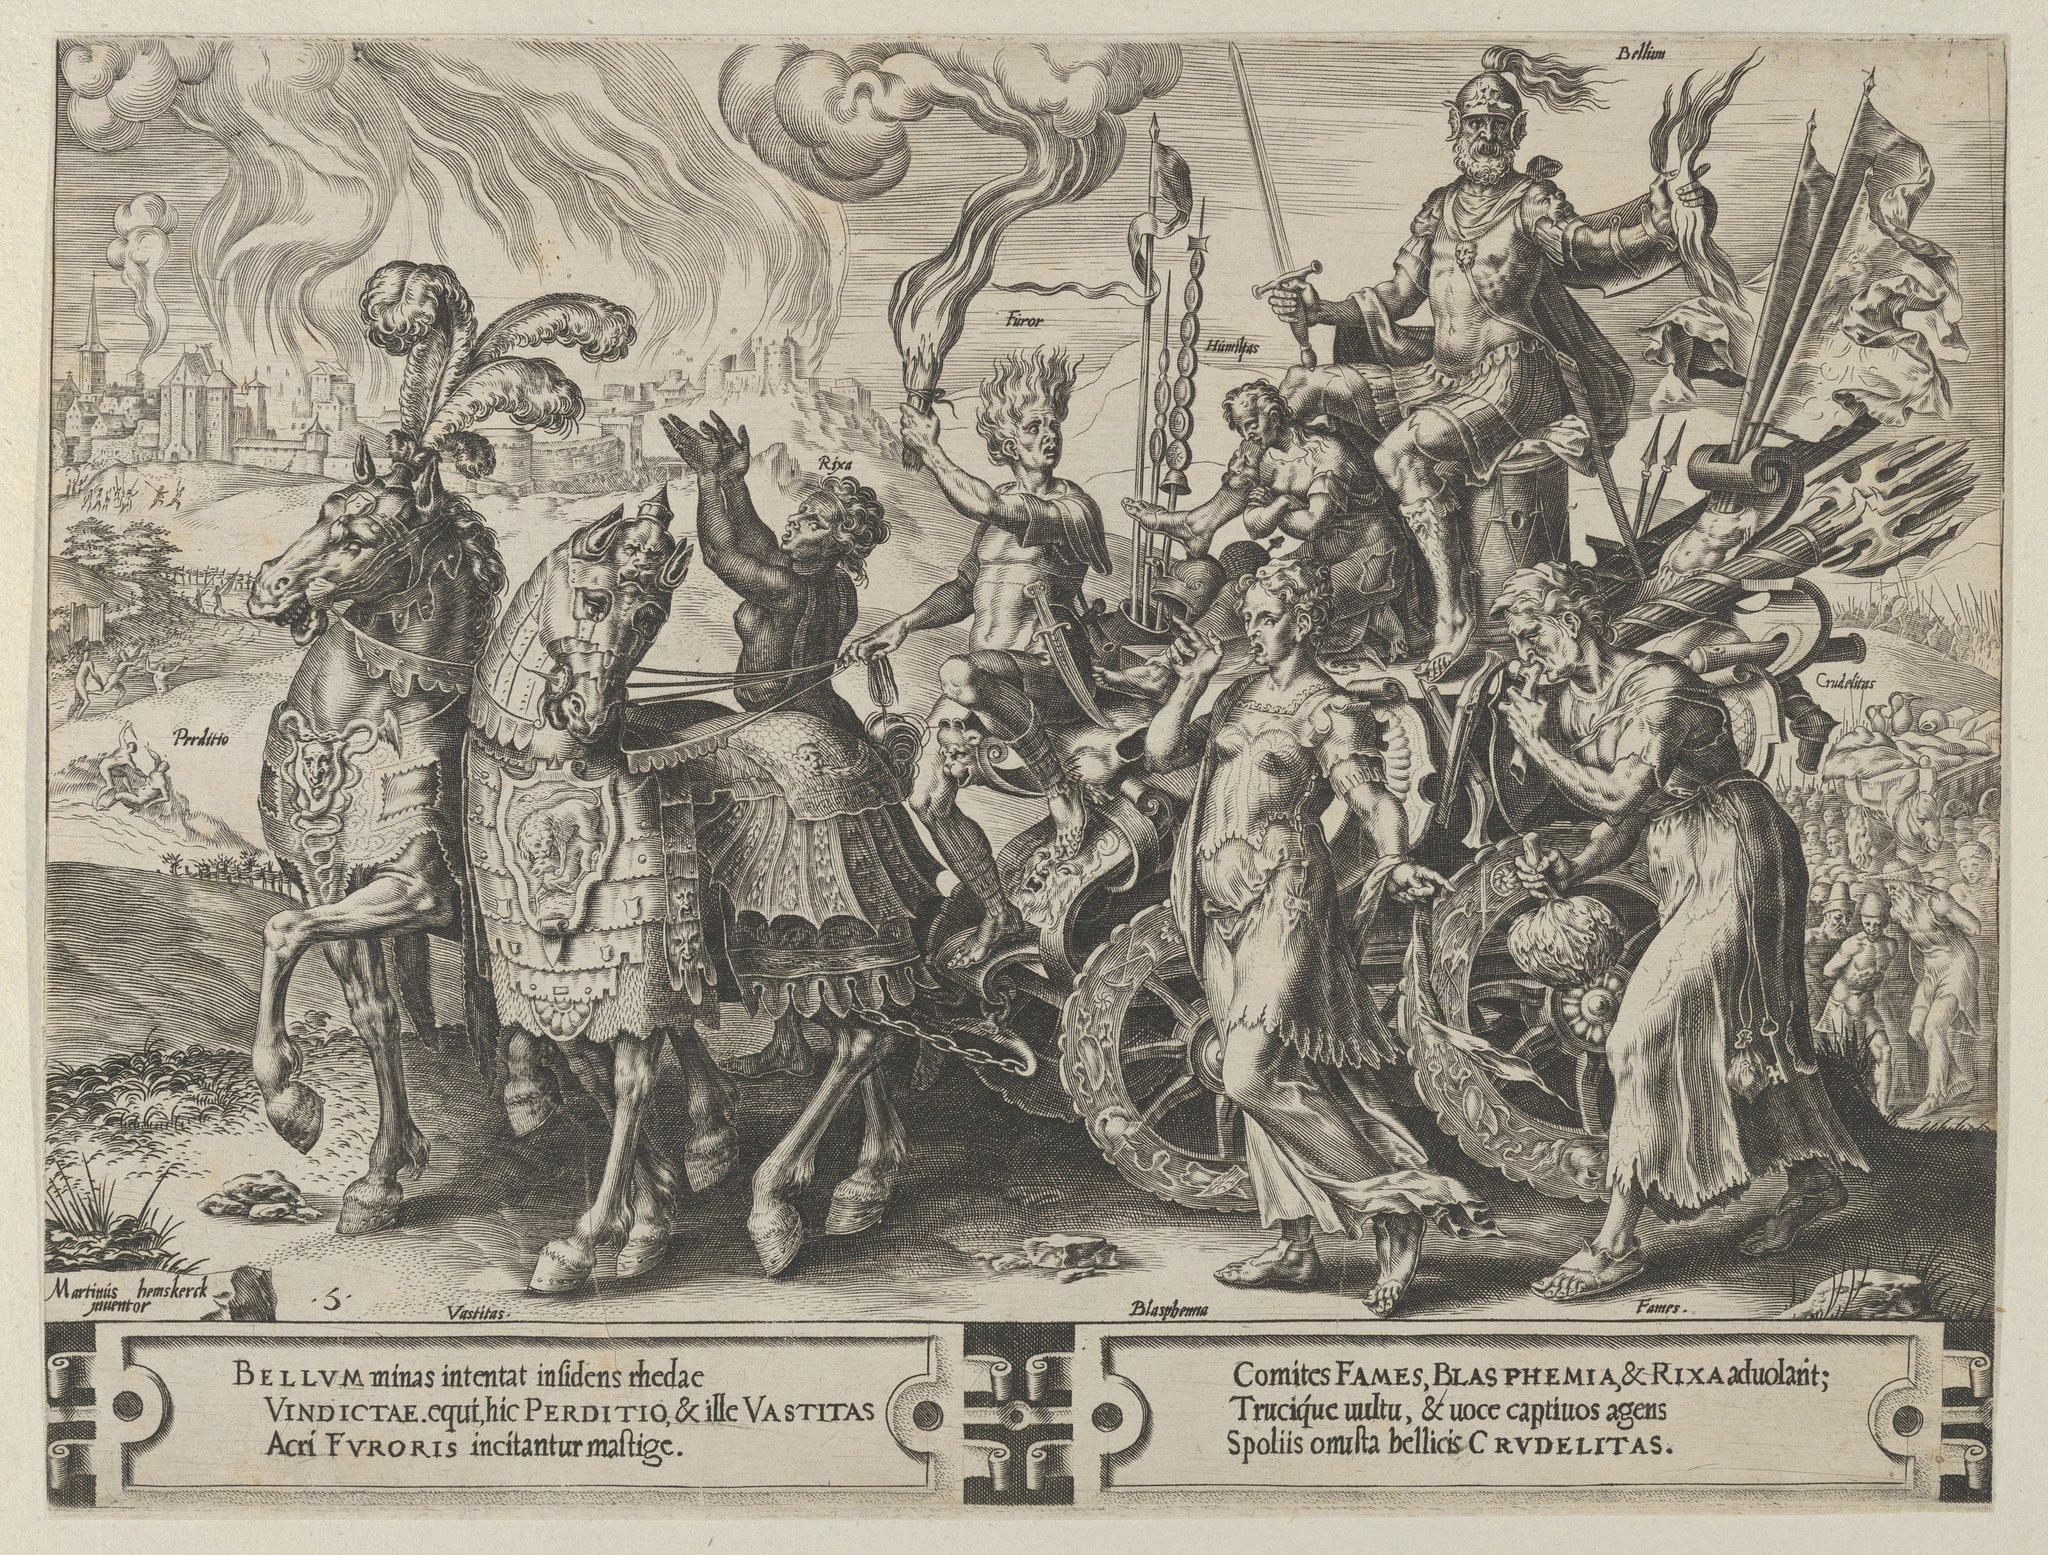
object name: print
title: The Triumph of War, from The Cycle of the Vicissitudes of Human Affairs, plate 5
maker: cornelis cort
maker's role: artist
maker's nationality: netherlandish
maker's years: 1533-1578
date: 1564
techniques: engraving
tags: men,women,horses,chariots